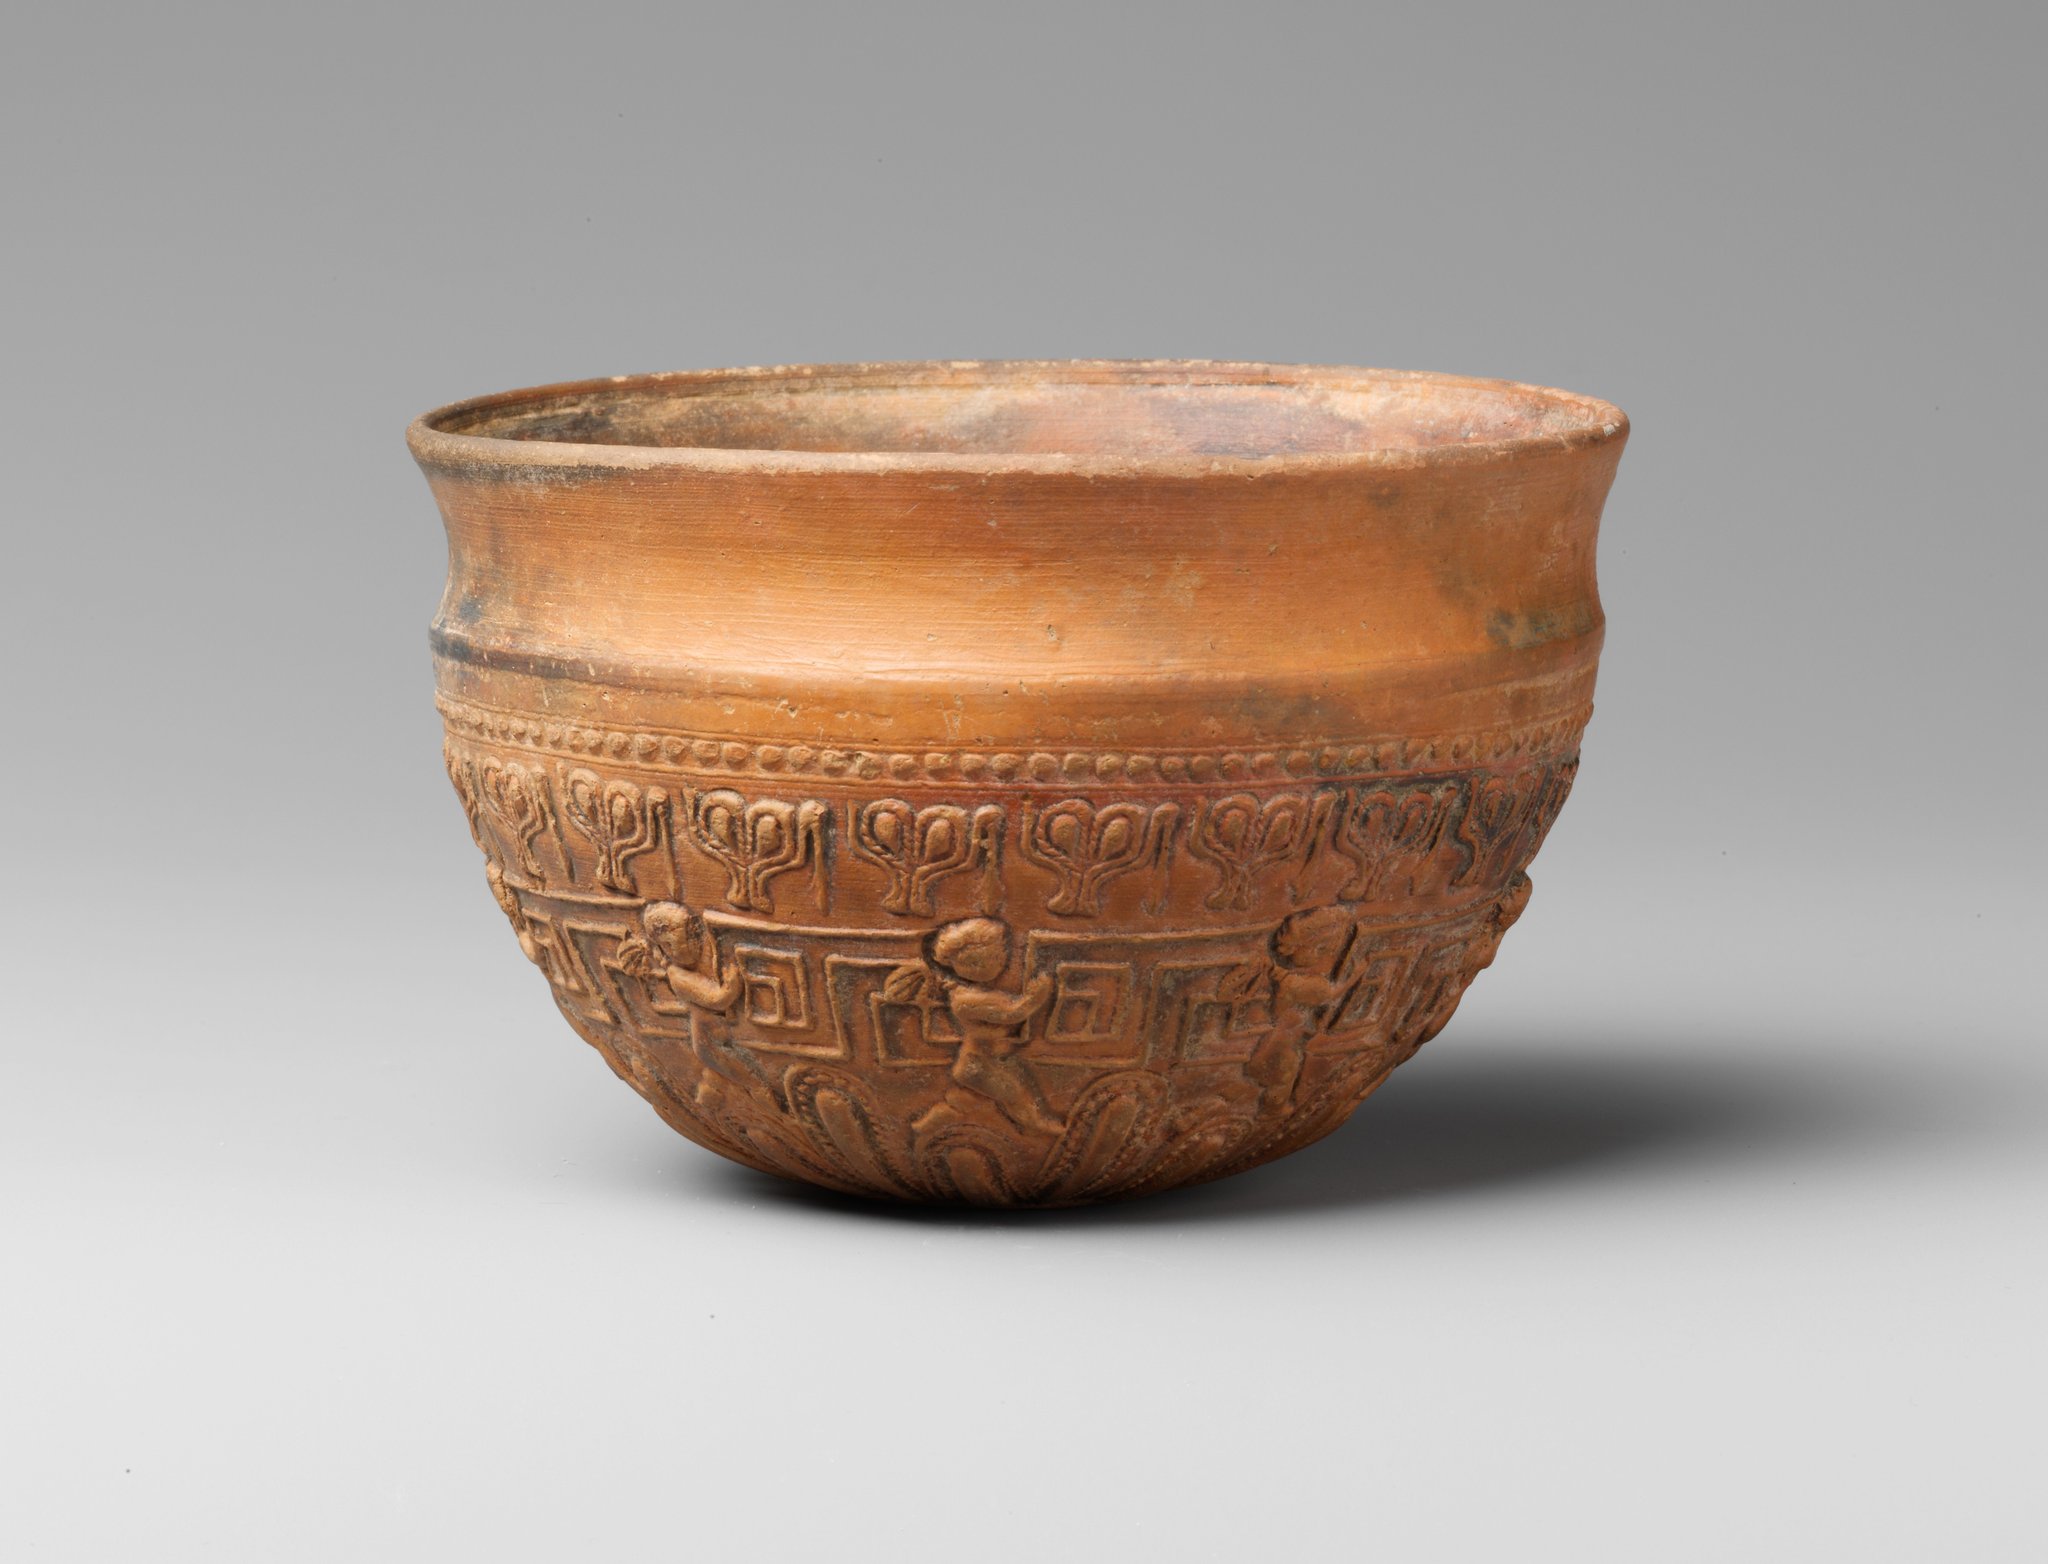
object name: megarian bowl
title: Terracotta Megarian bowl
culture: greek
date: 165-100 BCE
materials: terracotta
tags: eros